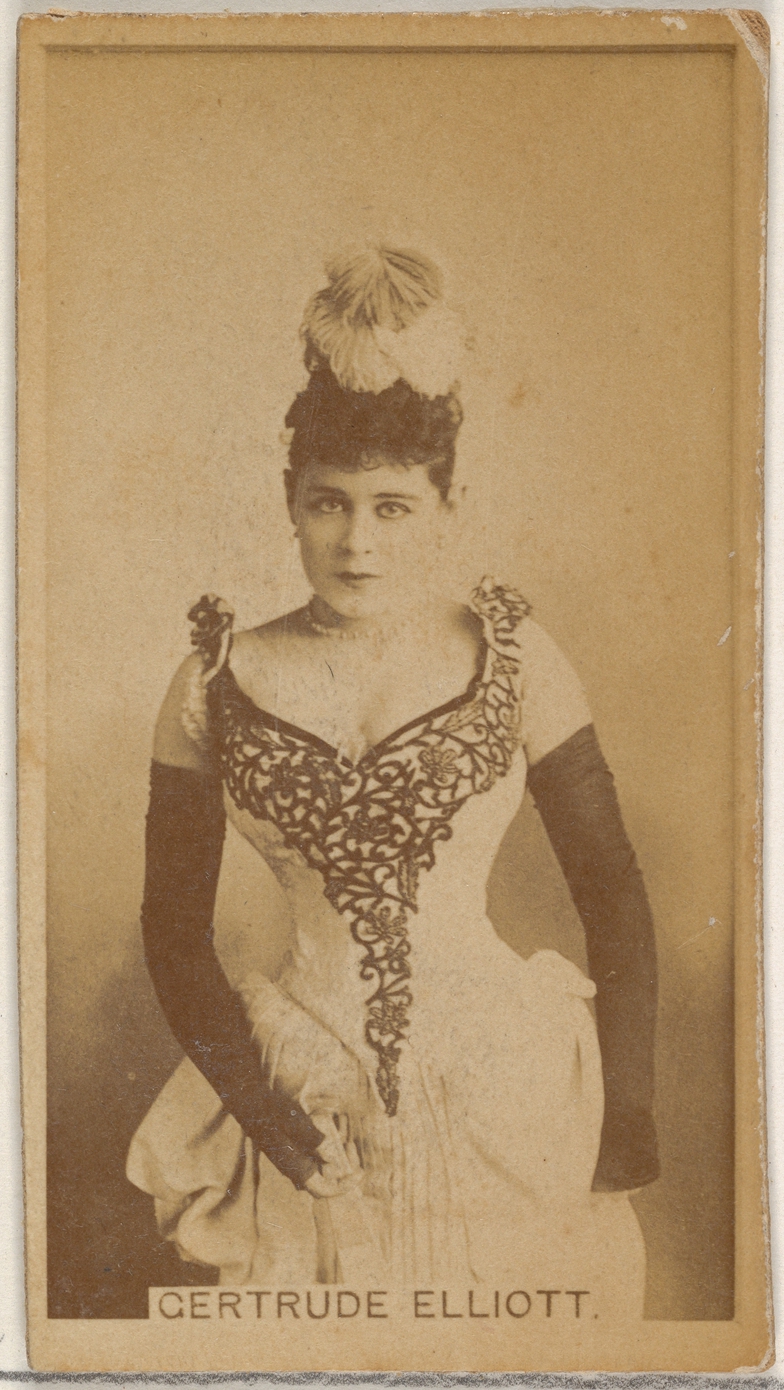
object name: photograph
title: Gertrude Elliott, from the Actors and Actresses series (N45, Type 8) for Virginia Brights Cigarettes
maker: allen & ginter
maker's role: publisher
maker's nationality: american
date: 1888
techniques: albumen silver print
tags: portraits,women,actresses